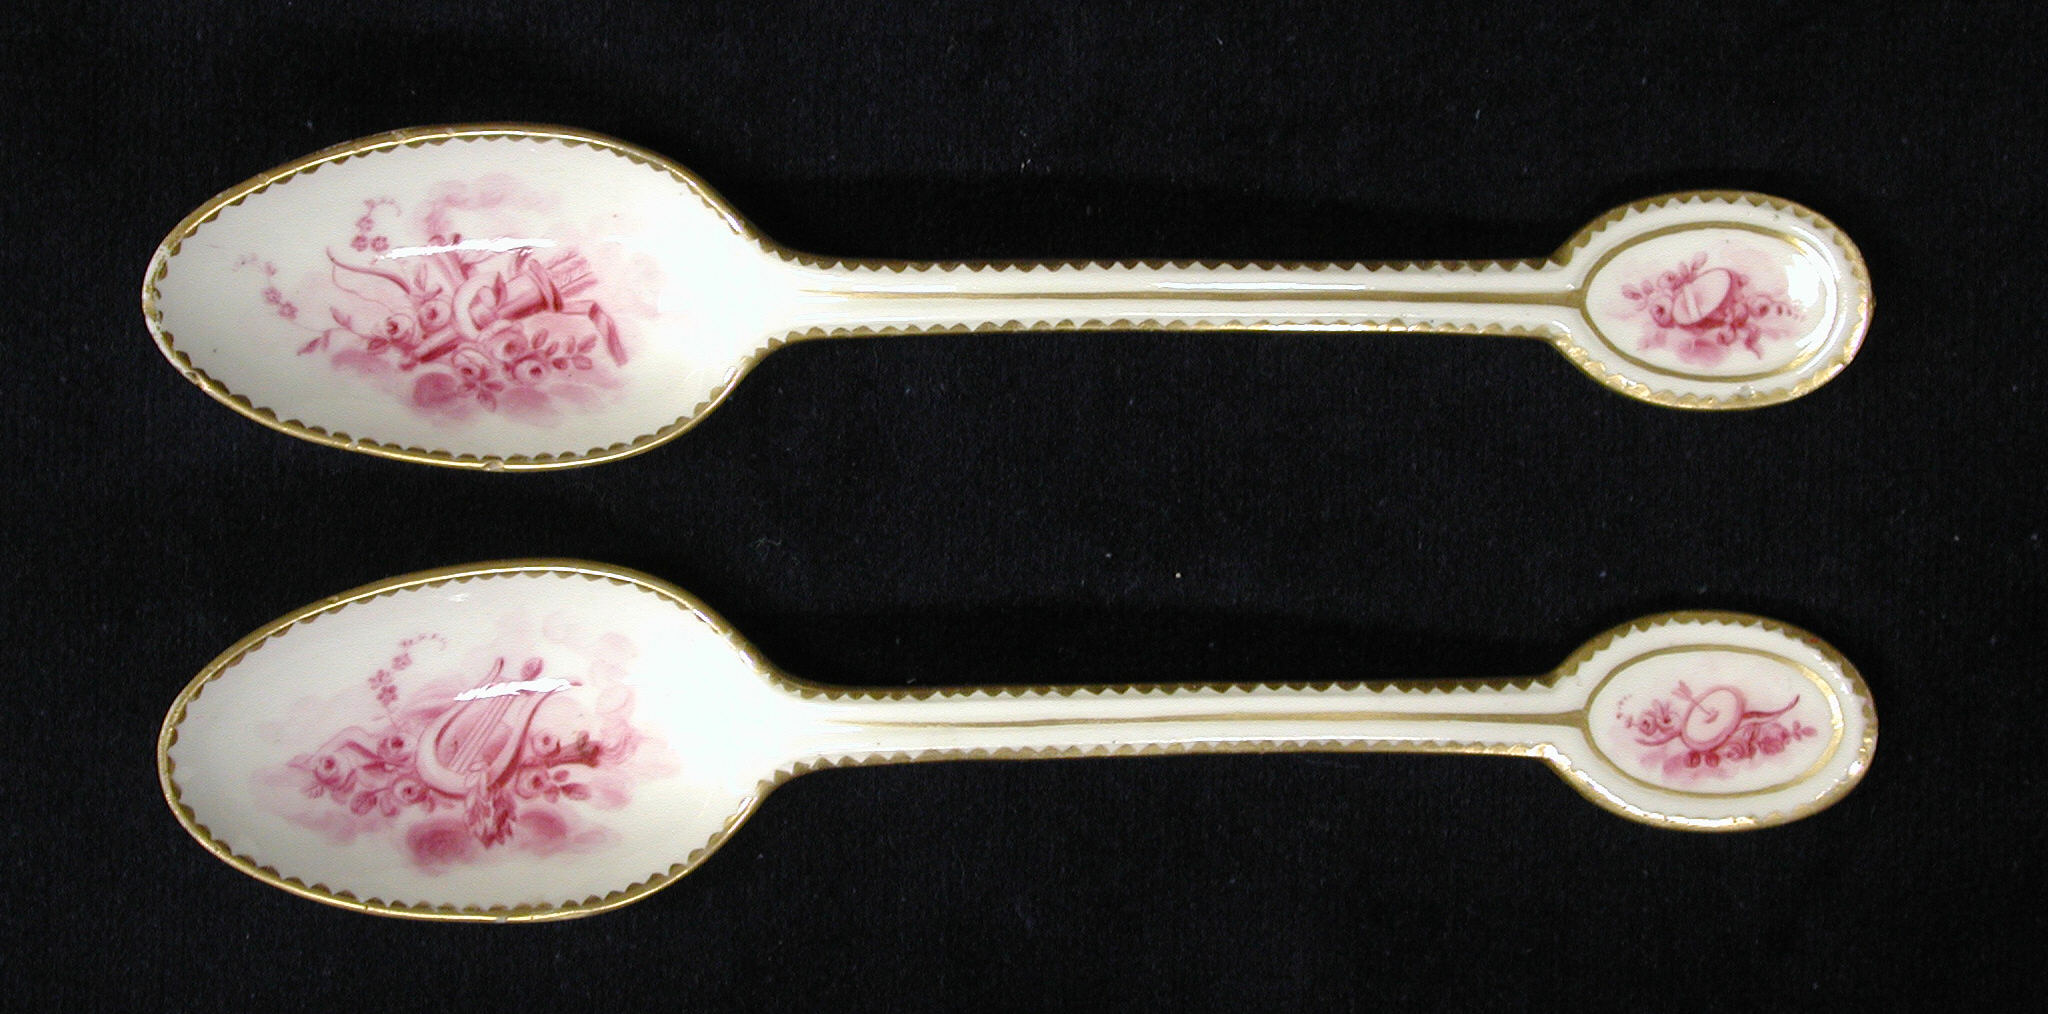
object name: tablespoon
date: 1701-1900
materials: soft paste porcelain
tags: harps,flowers